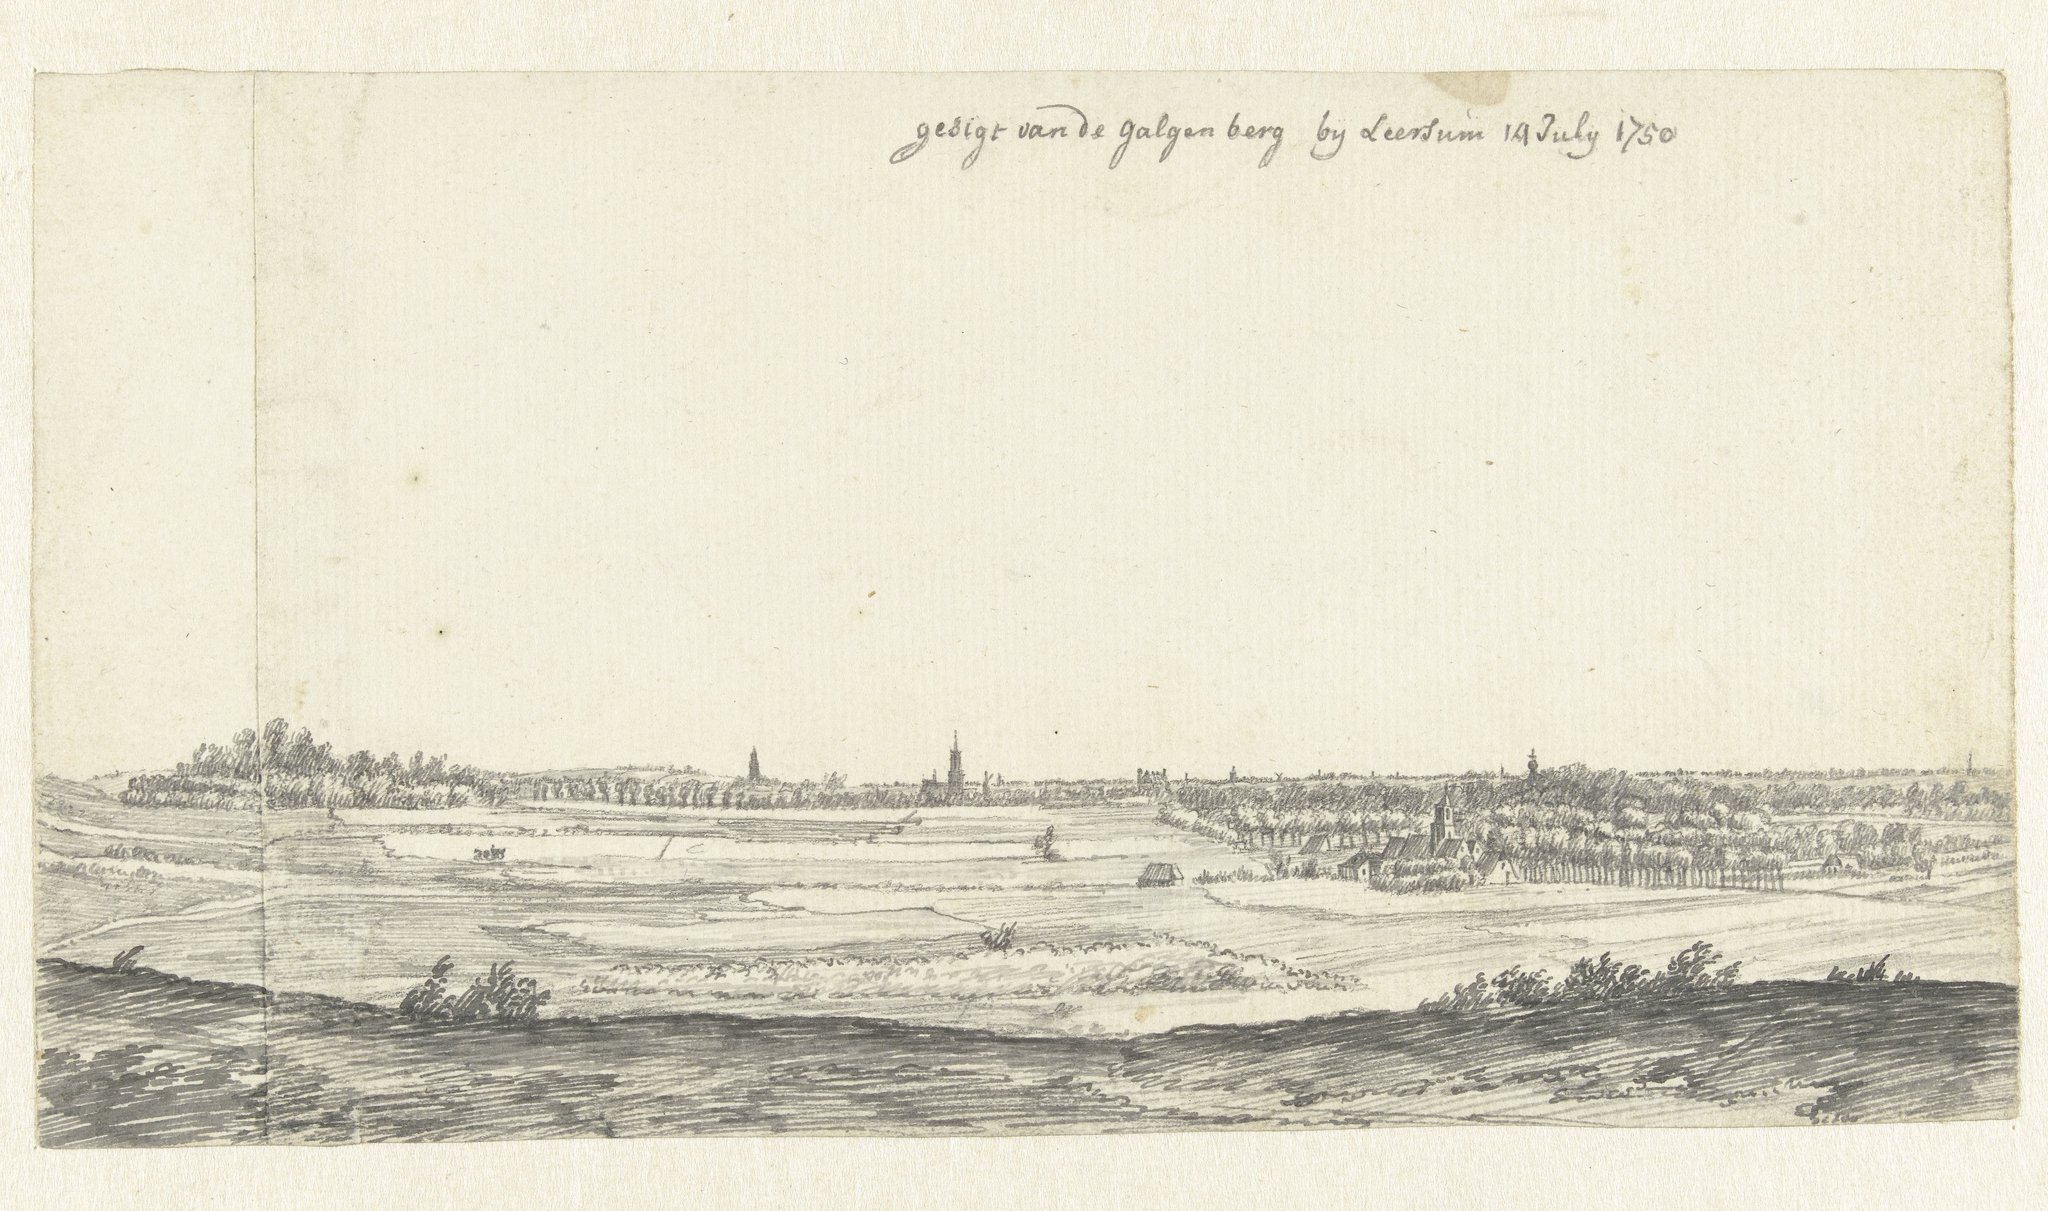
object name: drawing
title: Gezicht op Leersum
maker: jan de beijer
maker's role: draughtsman, print maker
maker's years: 1703-1780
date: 1750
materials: ink, paper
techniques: pen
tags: prospect of city, town panorama, silhouette of city